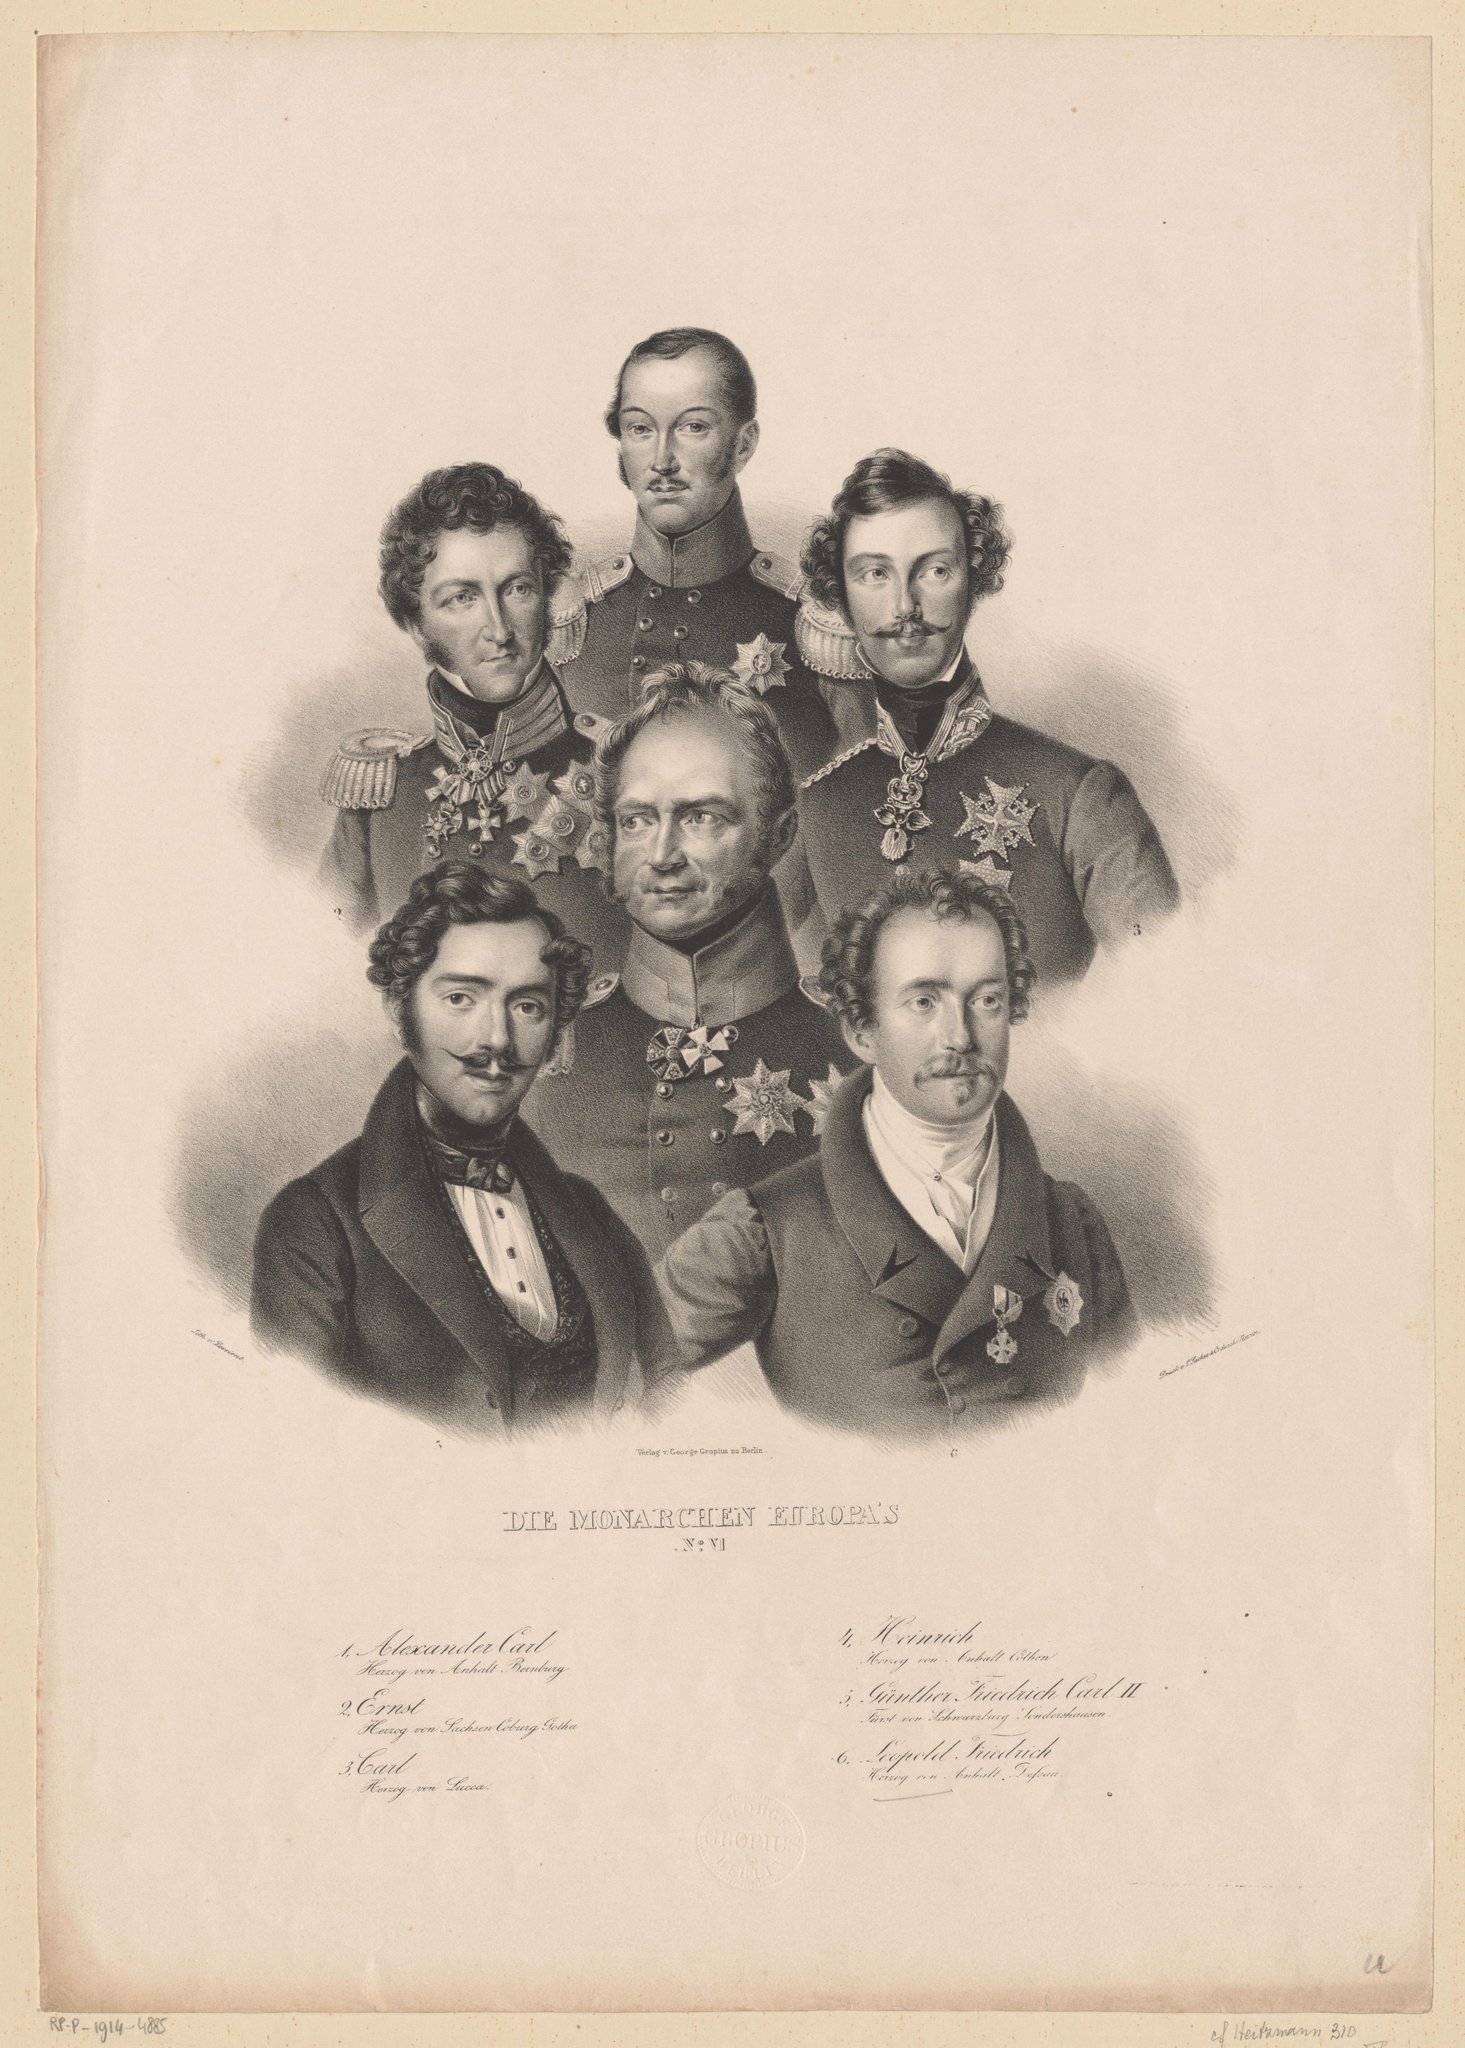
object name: print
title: Portretten van zes Europese vorsten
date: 1834-1844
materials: paper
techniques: lithograph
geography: berlin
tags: prince, historical persons, king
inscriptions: collector's mark: Lugt 2228, check stamp: Lugt 4221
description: Portretten van Alexander Karl von Anhalt-Bernburg, Ernst I van Saksen-Coburg en Gotha, Karel Lodewijk Ferdinand van Bourbon-Parma, Hendrik van Anhalt-Köthen, Günther Friedrich Karl II. von Schwarzburg-Sondershausen, en van Leopold IV Friedrich Herzog von Anhalt-Dessau.